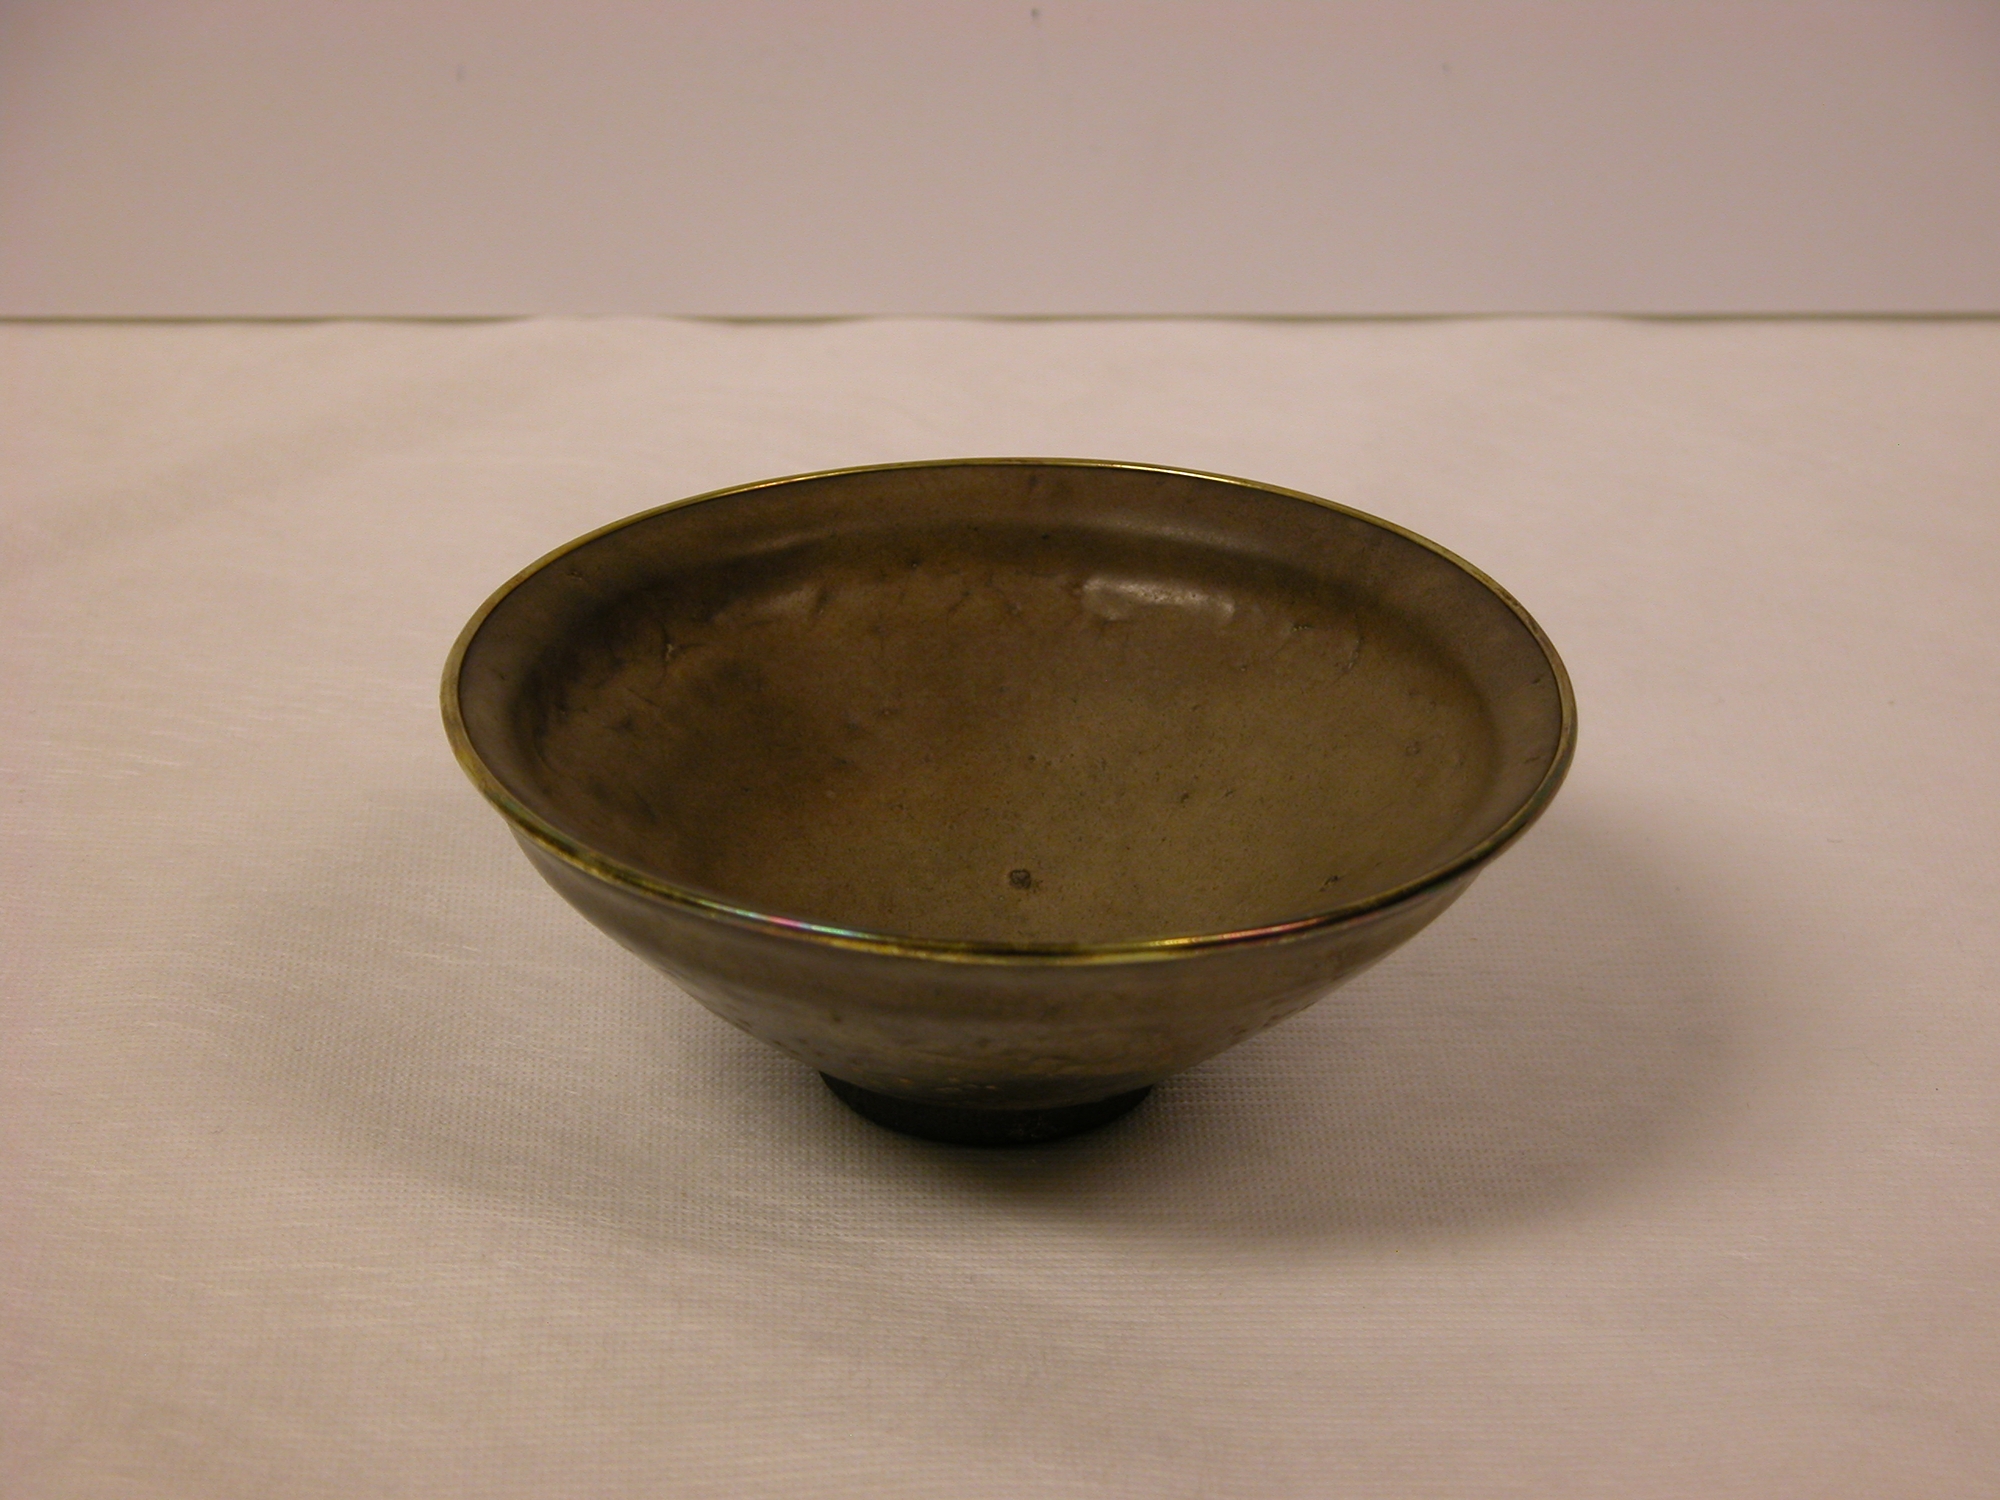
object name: bowl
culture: chinese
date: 960-1279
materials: pottery